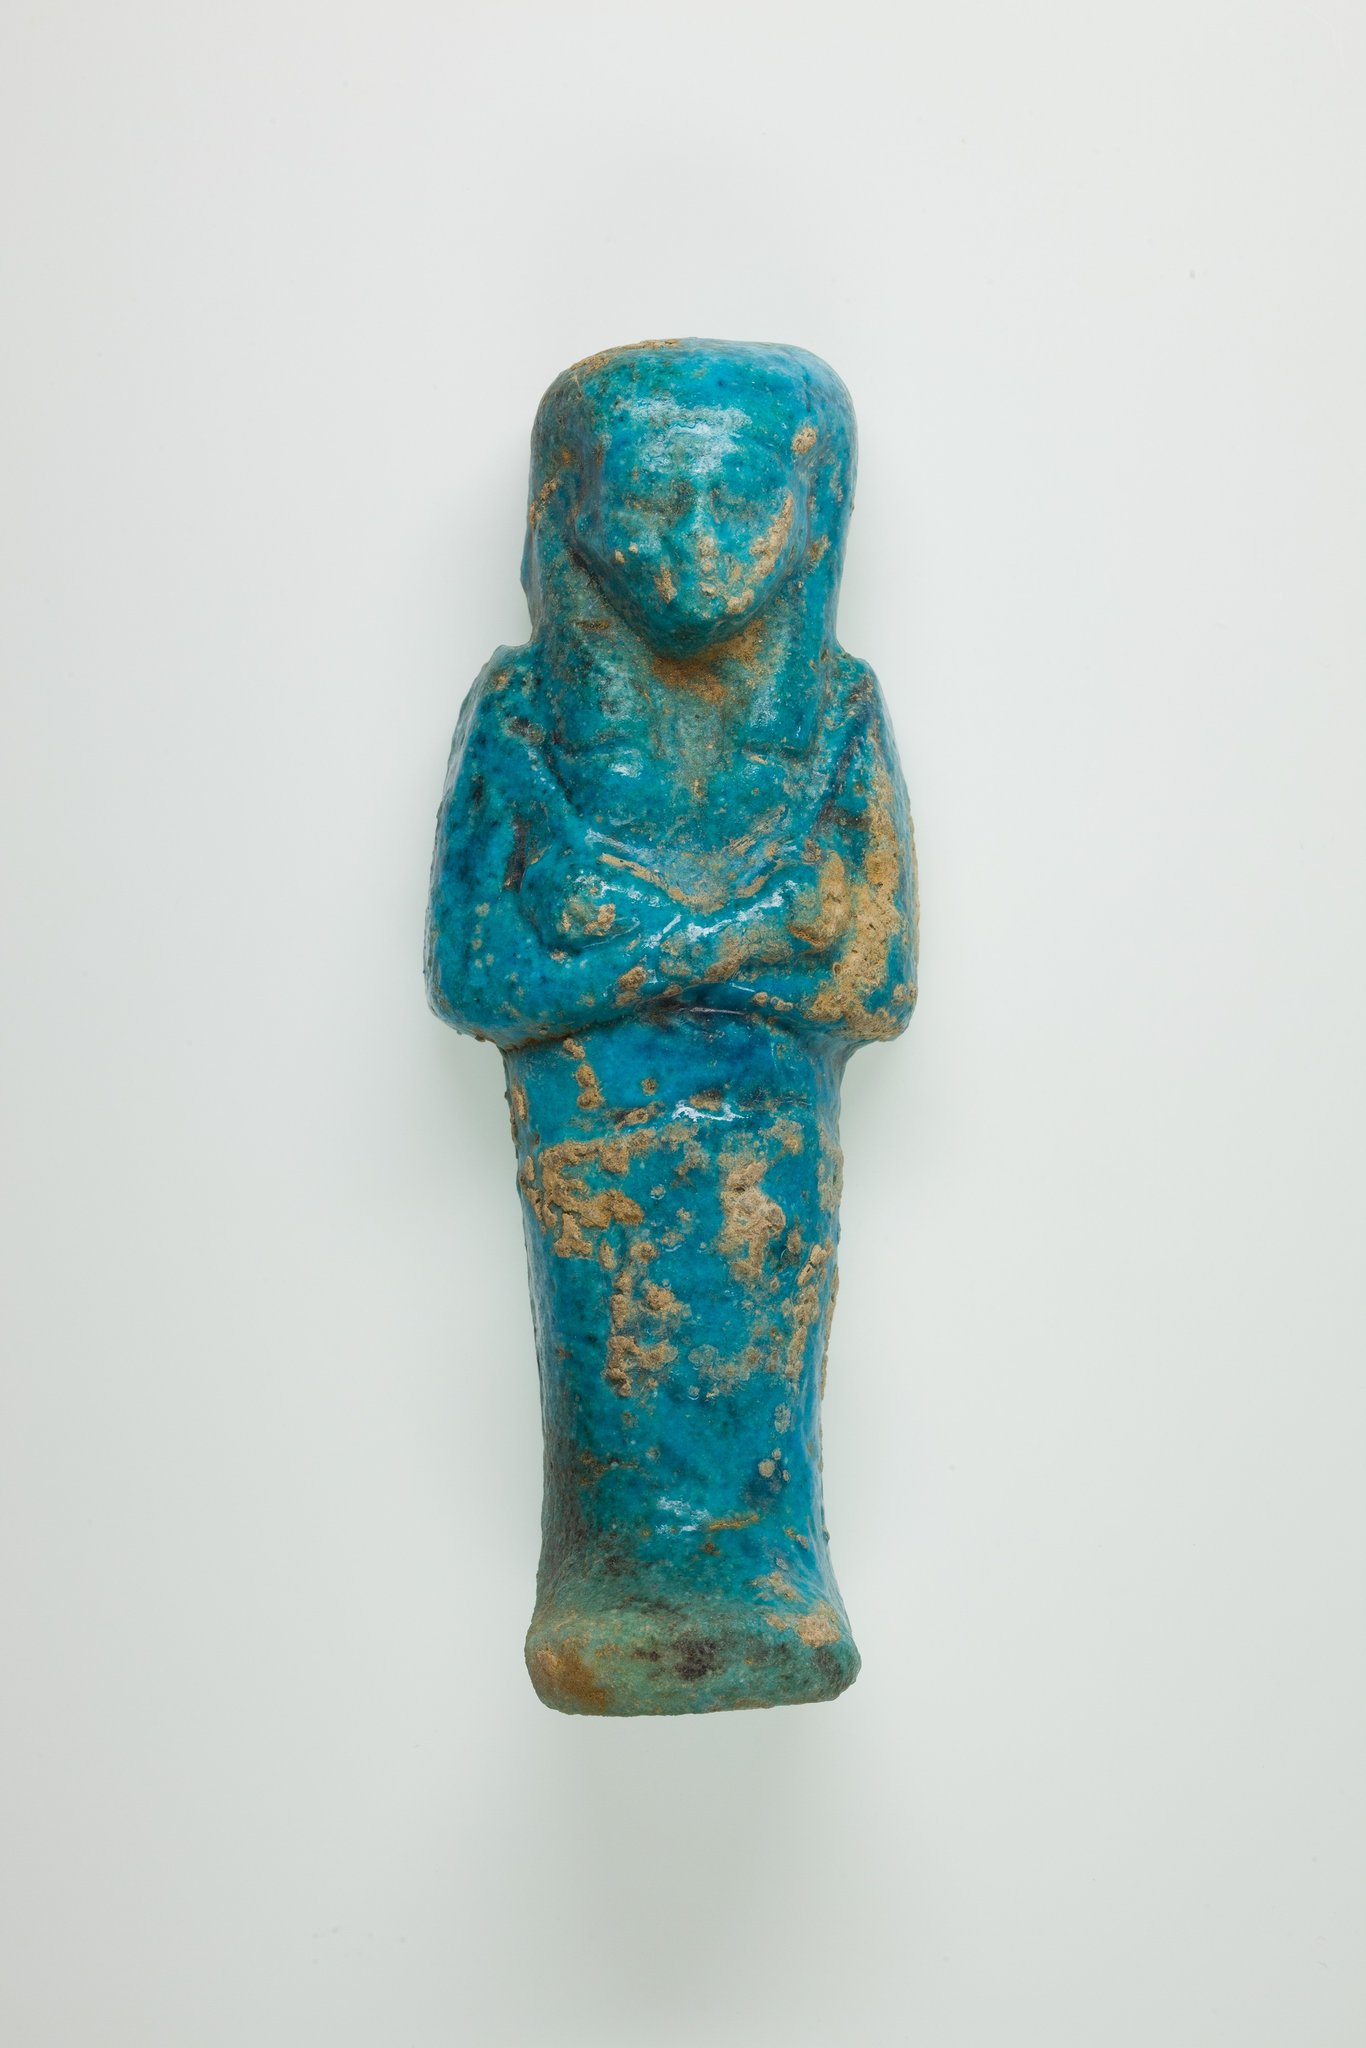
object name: shabti, henettawy c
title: Worker Shabti of Henettawy (C), Daughter of Isetemkheb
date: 990-970 BCE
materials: faience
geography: egypt